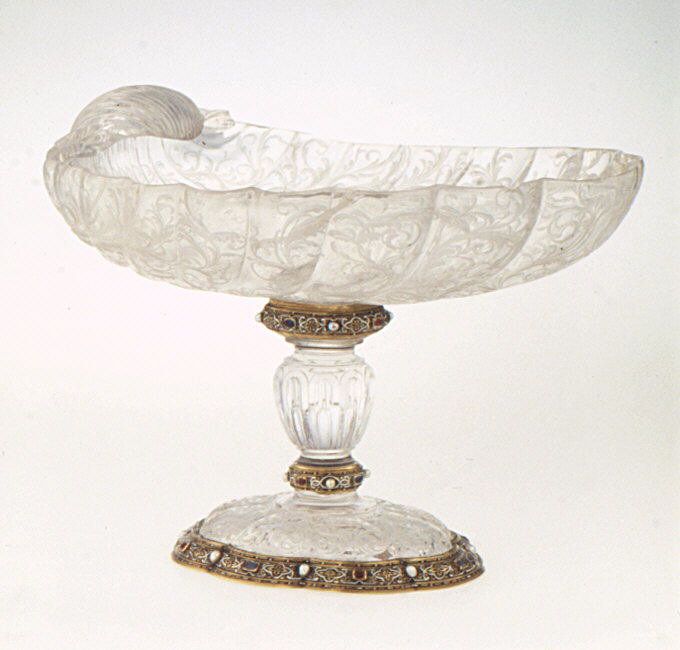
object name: tazza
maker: reinhold vasters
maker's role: designer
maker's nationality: german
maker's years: 1827-1909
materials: enamel, gold, pearl, quartz, gemstone